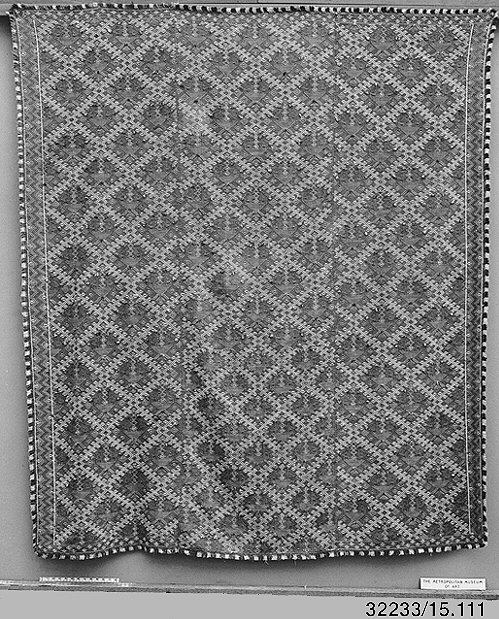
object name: bedspread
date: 1650-1700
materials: silk